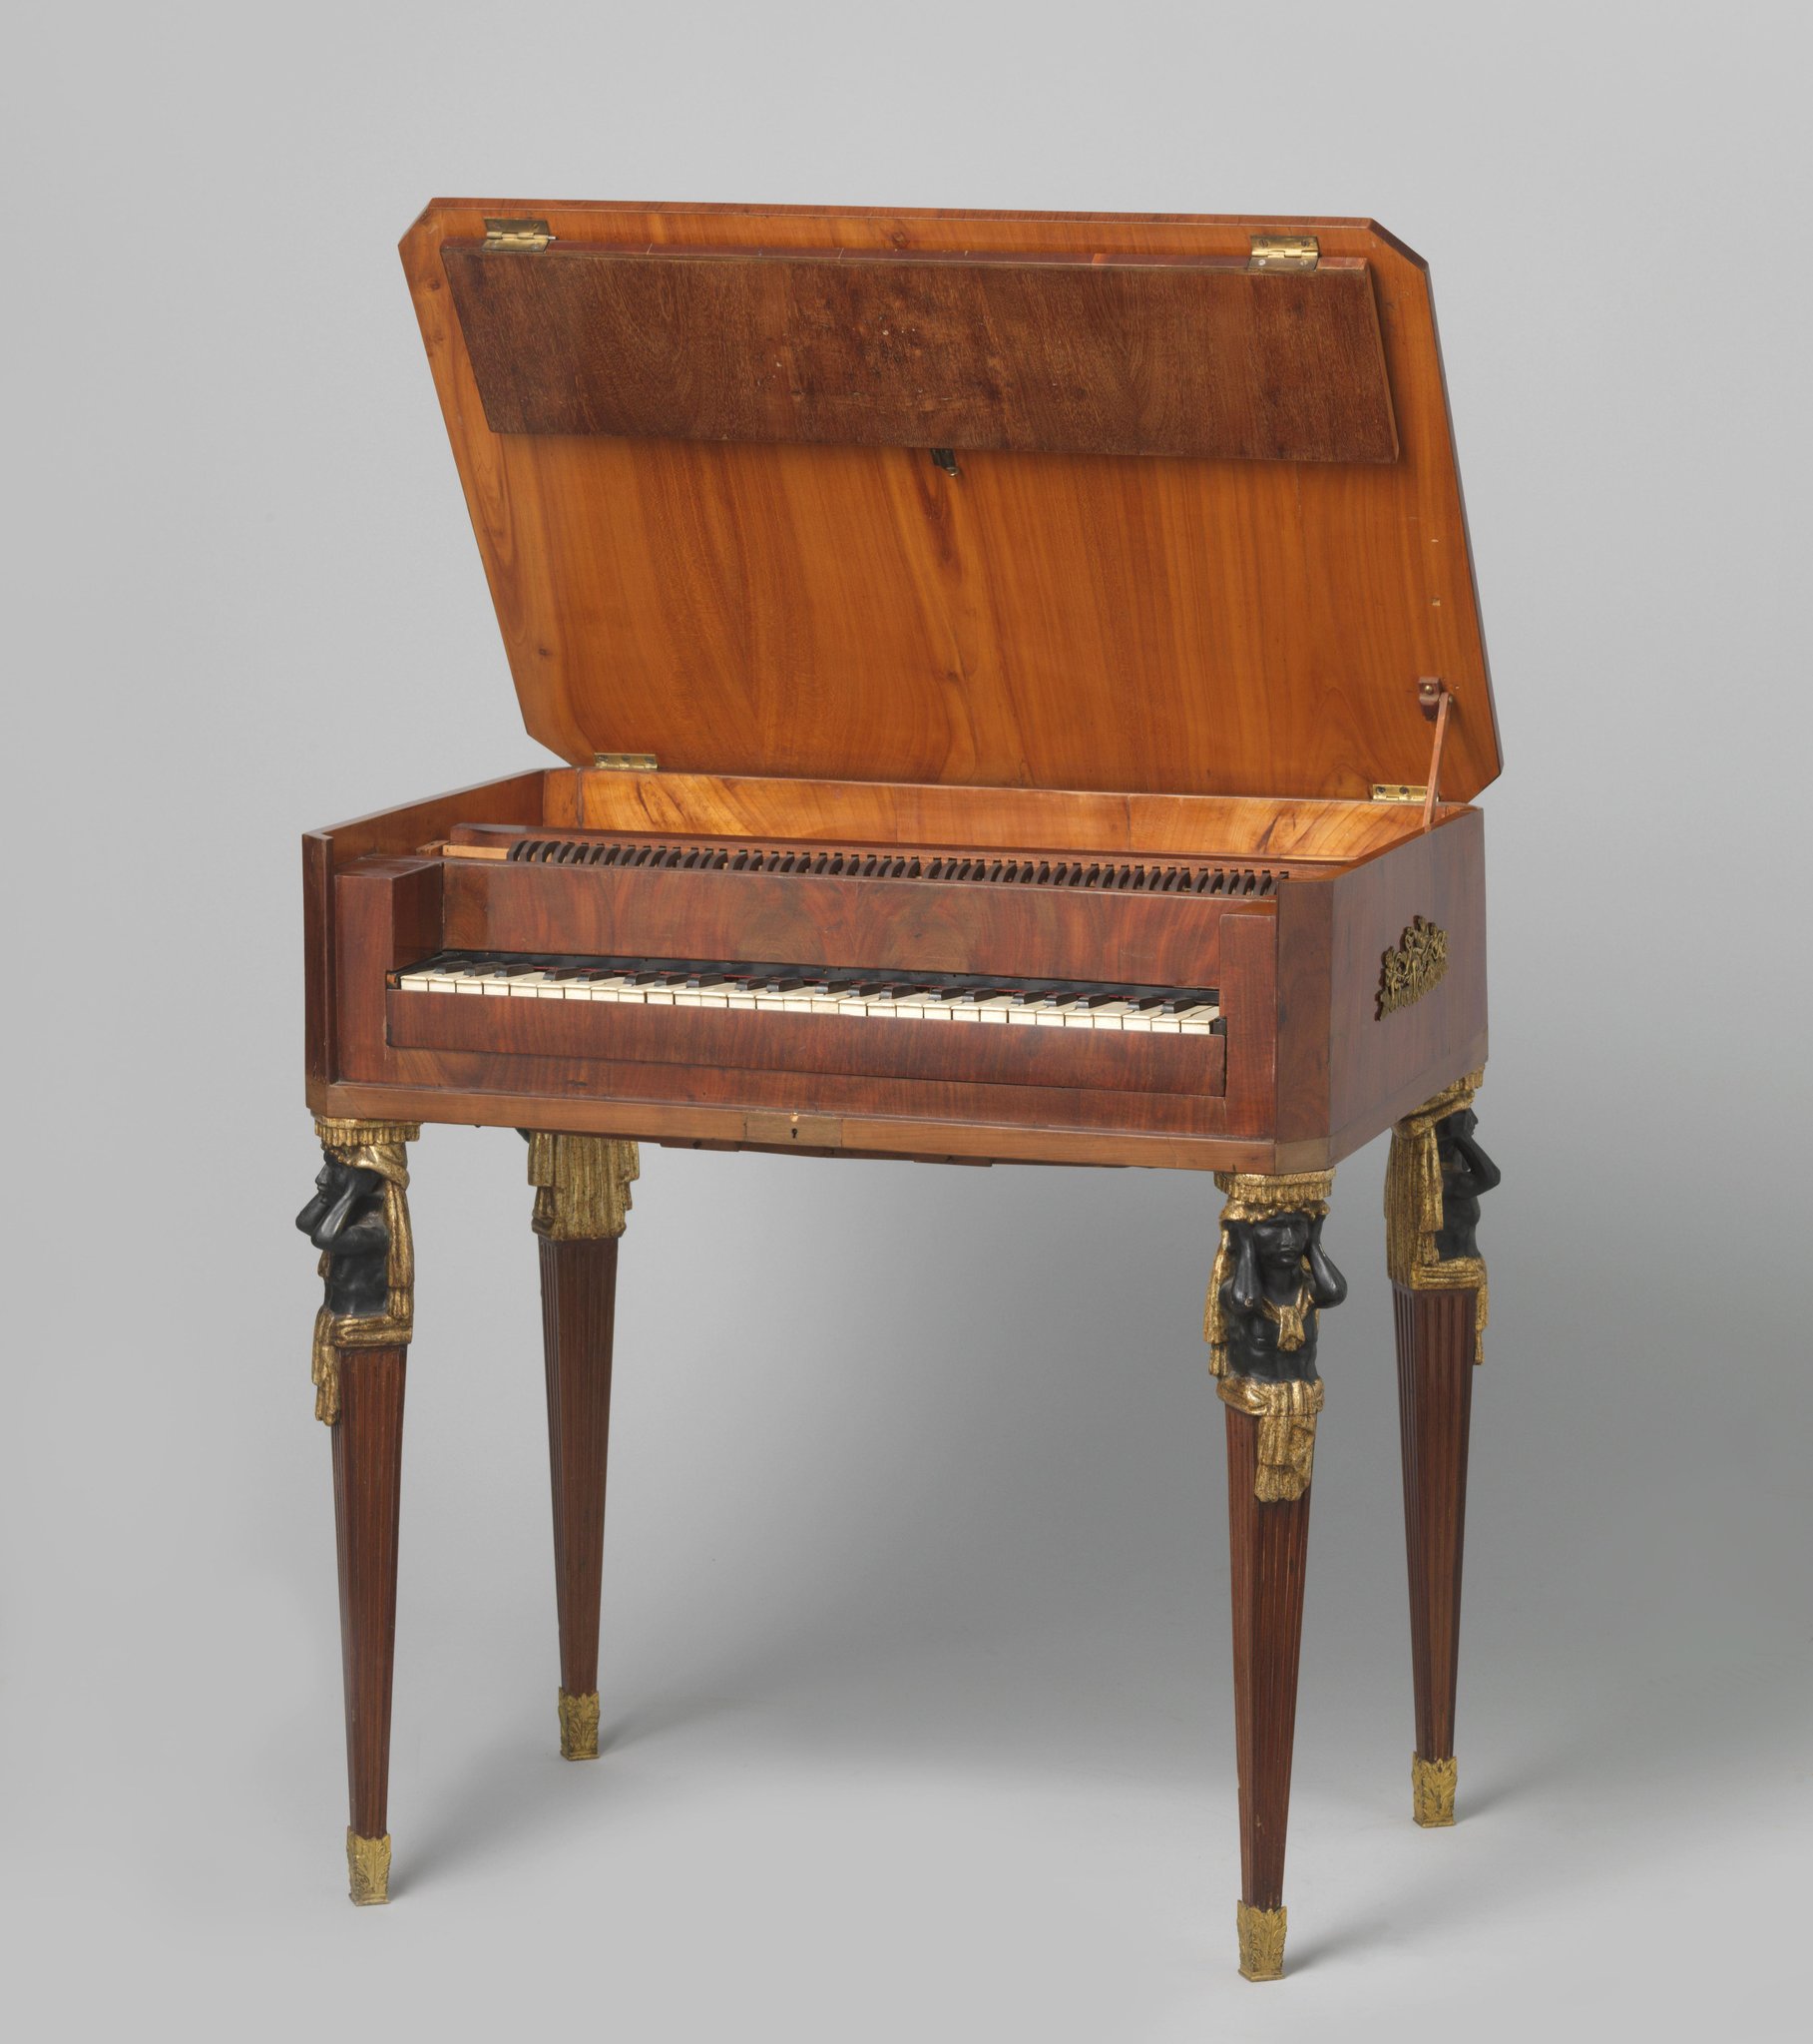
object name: keyboard instrument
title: Square piano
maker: Anonymous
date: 1810-1820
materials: bone, wood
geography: austria